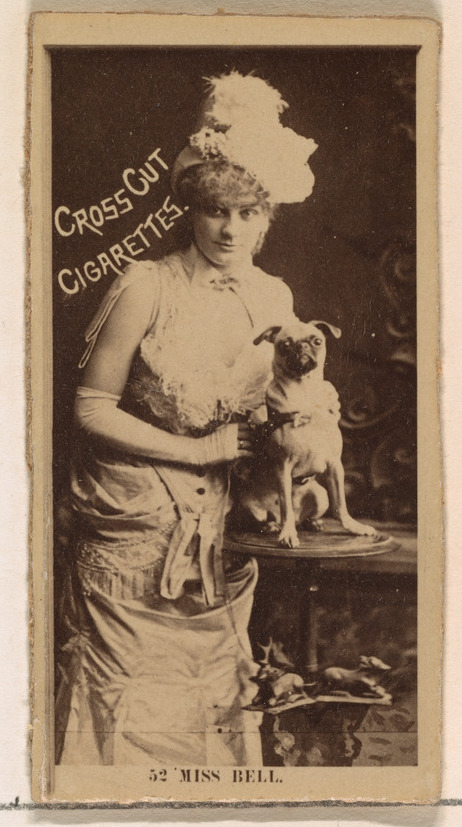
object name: print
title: Card Number 52, Miss Bell, from the Actors and Actresses series (N145-2) issued by Duke Sons & Co. to promote Cross Cut Cigarettes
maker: w. duke, sons & co.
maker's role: publisher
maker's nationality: american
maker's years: 1870-1920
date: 1880-1889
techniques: albumen silver print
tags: portraits,women,dogs,actresses